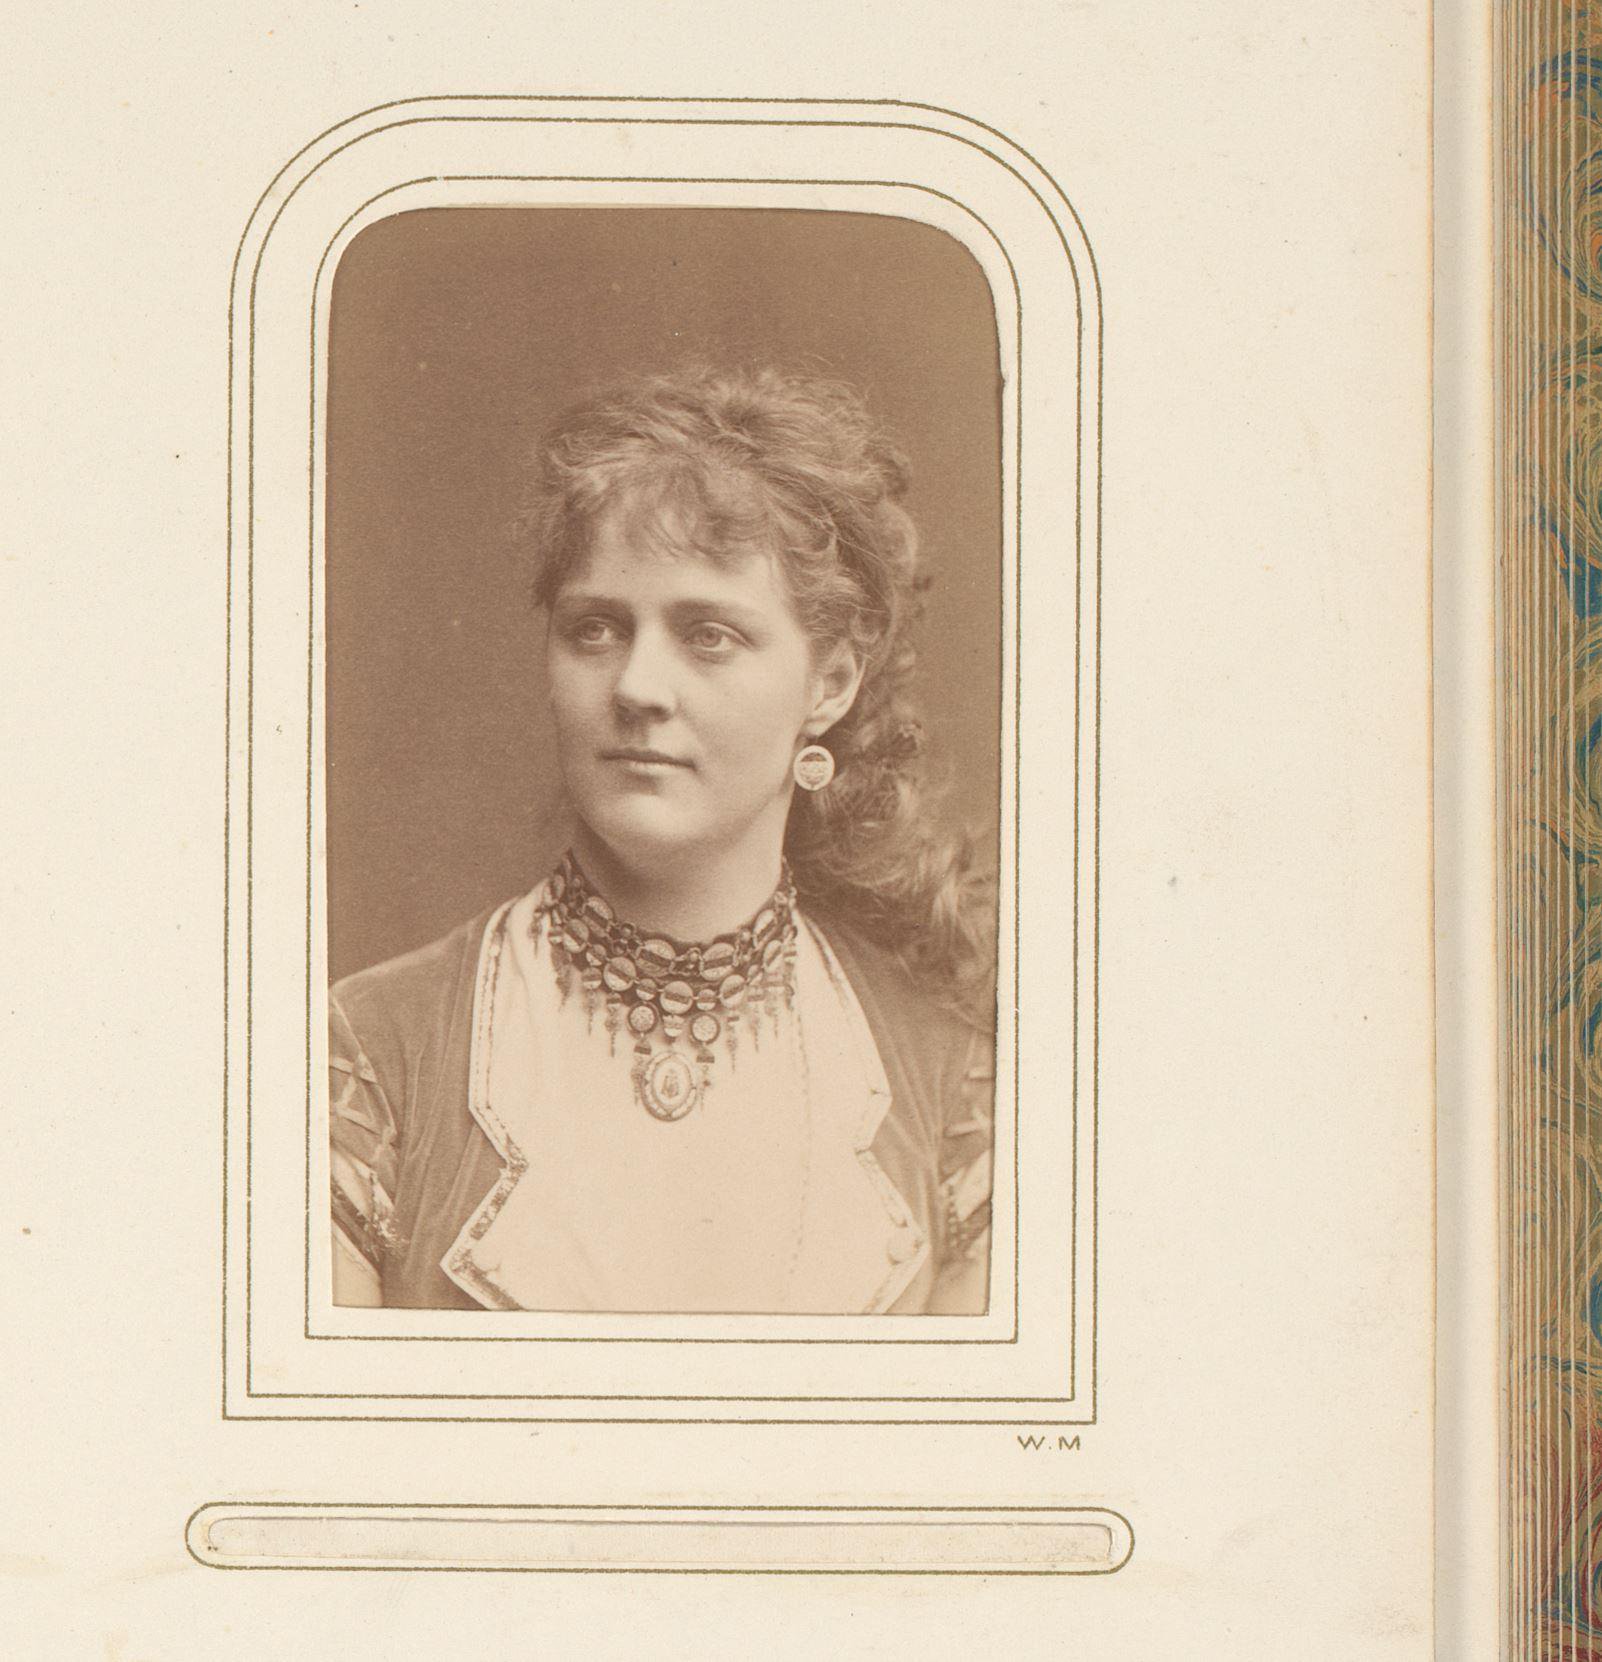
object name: carte de visite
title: Portret van Helga Franckenfeldt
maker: gösta florman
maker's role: fotograaf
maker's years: 1831-1900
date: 1870-1885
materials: cardboard, photographic support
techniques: albumen print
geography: stockholm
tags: historical persons - bb - woman, portrait of actor, actress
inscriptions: inscription: ‘Gösta Florman/ STOCKHOLM/ 28A Regeringsgatan 28 A.’, annotation: ‘Helga Franckenfeldt’